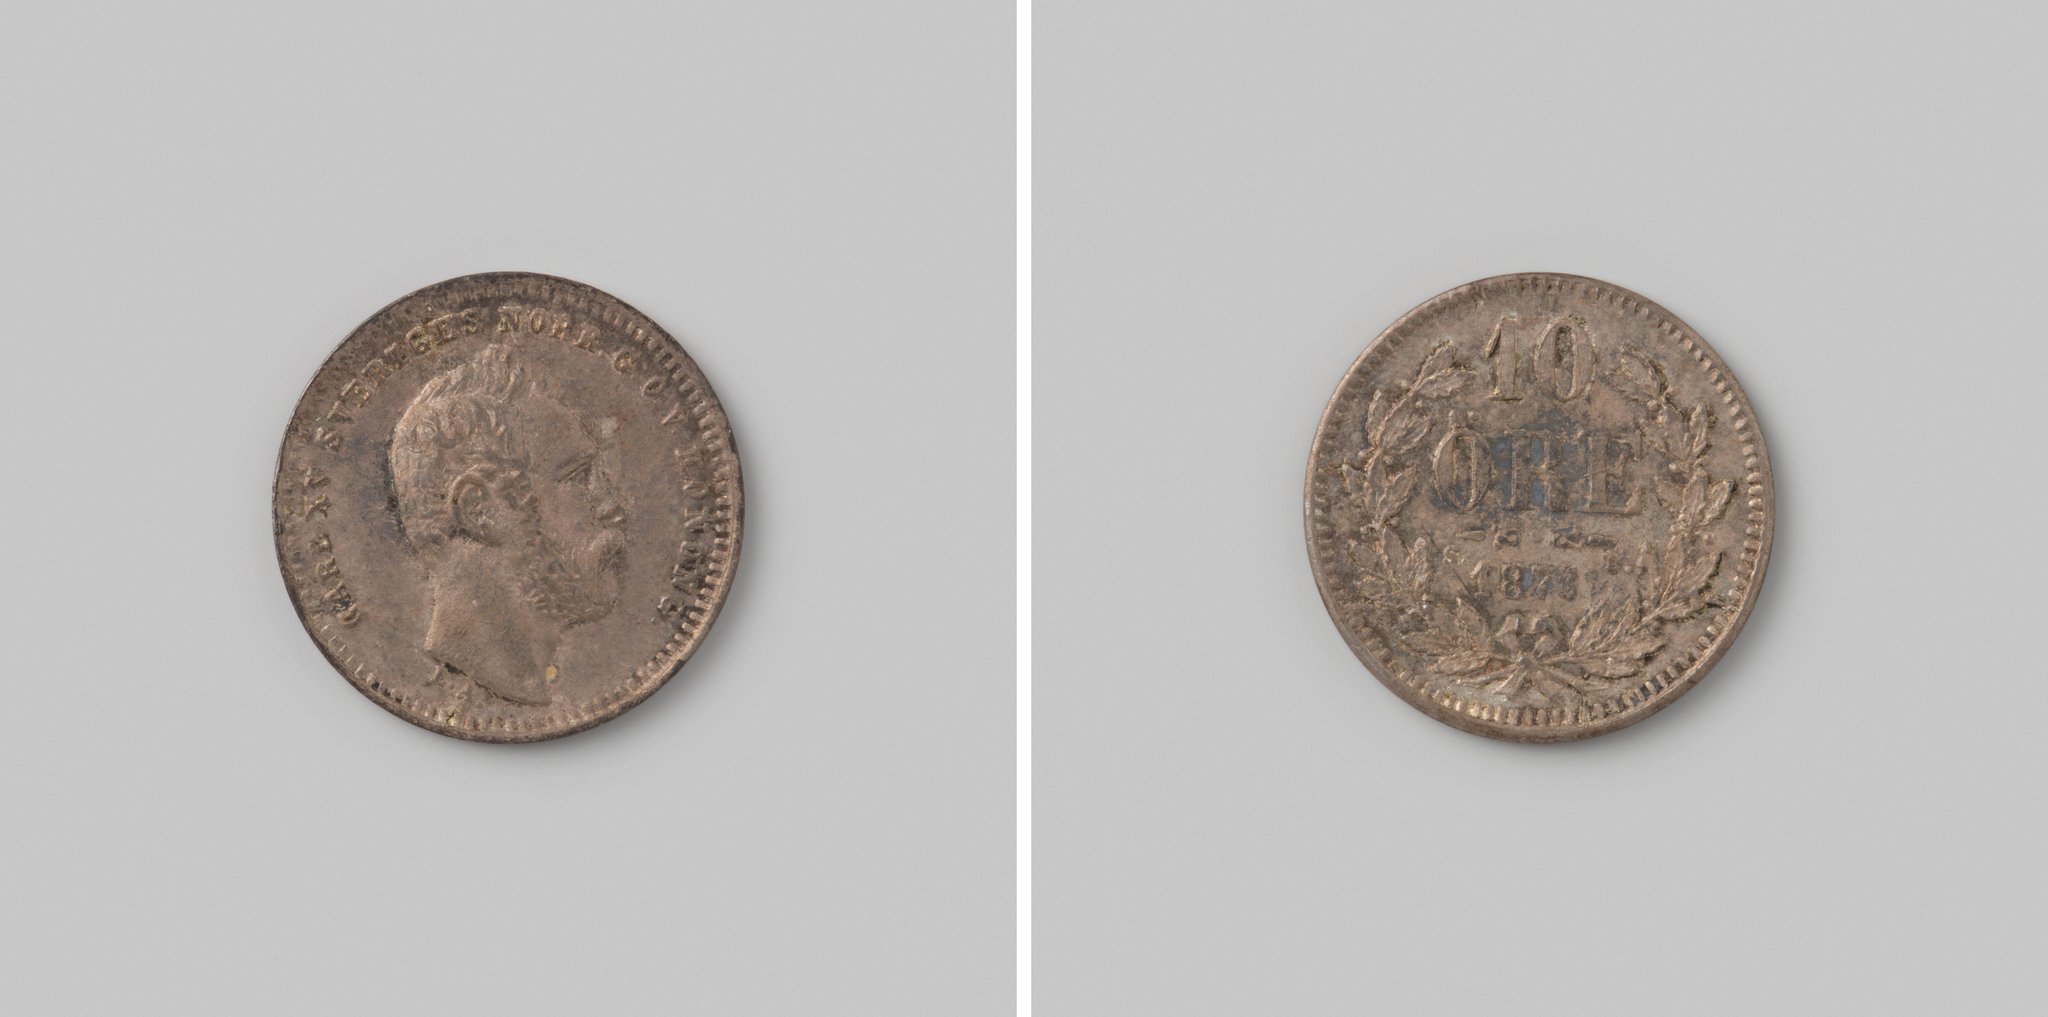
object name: coin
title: Zweden, Karel XV, 10 öre, 1871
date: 1871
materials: silver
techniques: striking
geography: slot rörstrand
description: Zilveren munt. Voorzijde: borstbeeld van de koning naar rechts. Keerzijde: binnen twee samengebonden takken waarde-aanduiding in twee regels. Daaronder jaartal. Gladde rand.